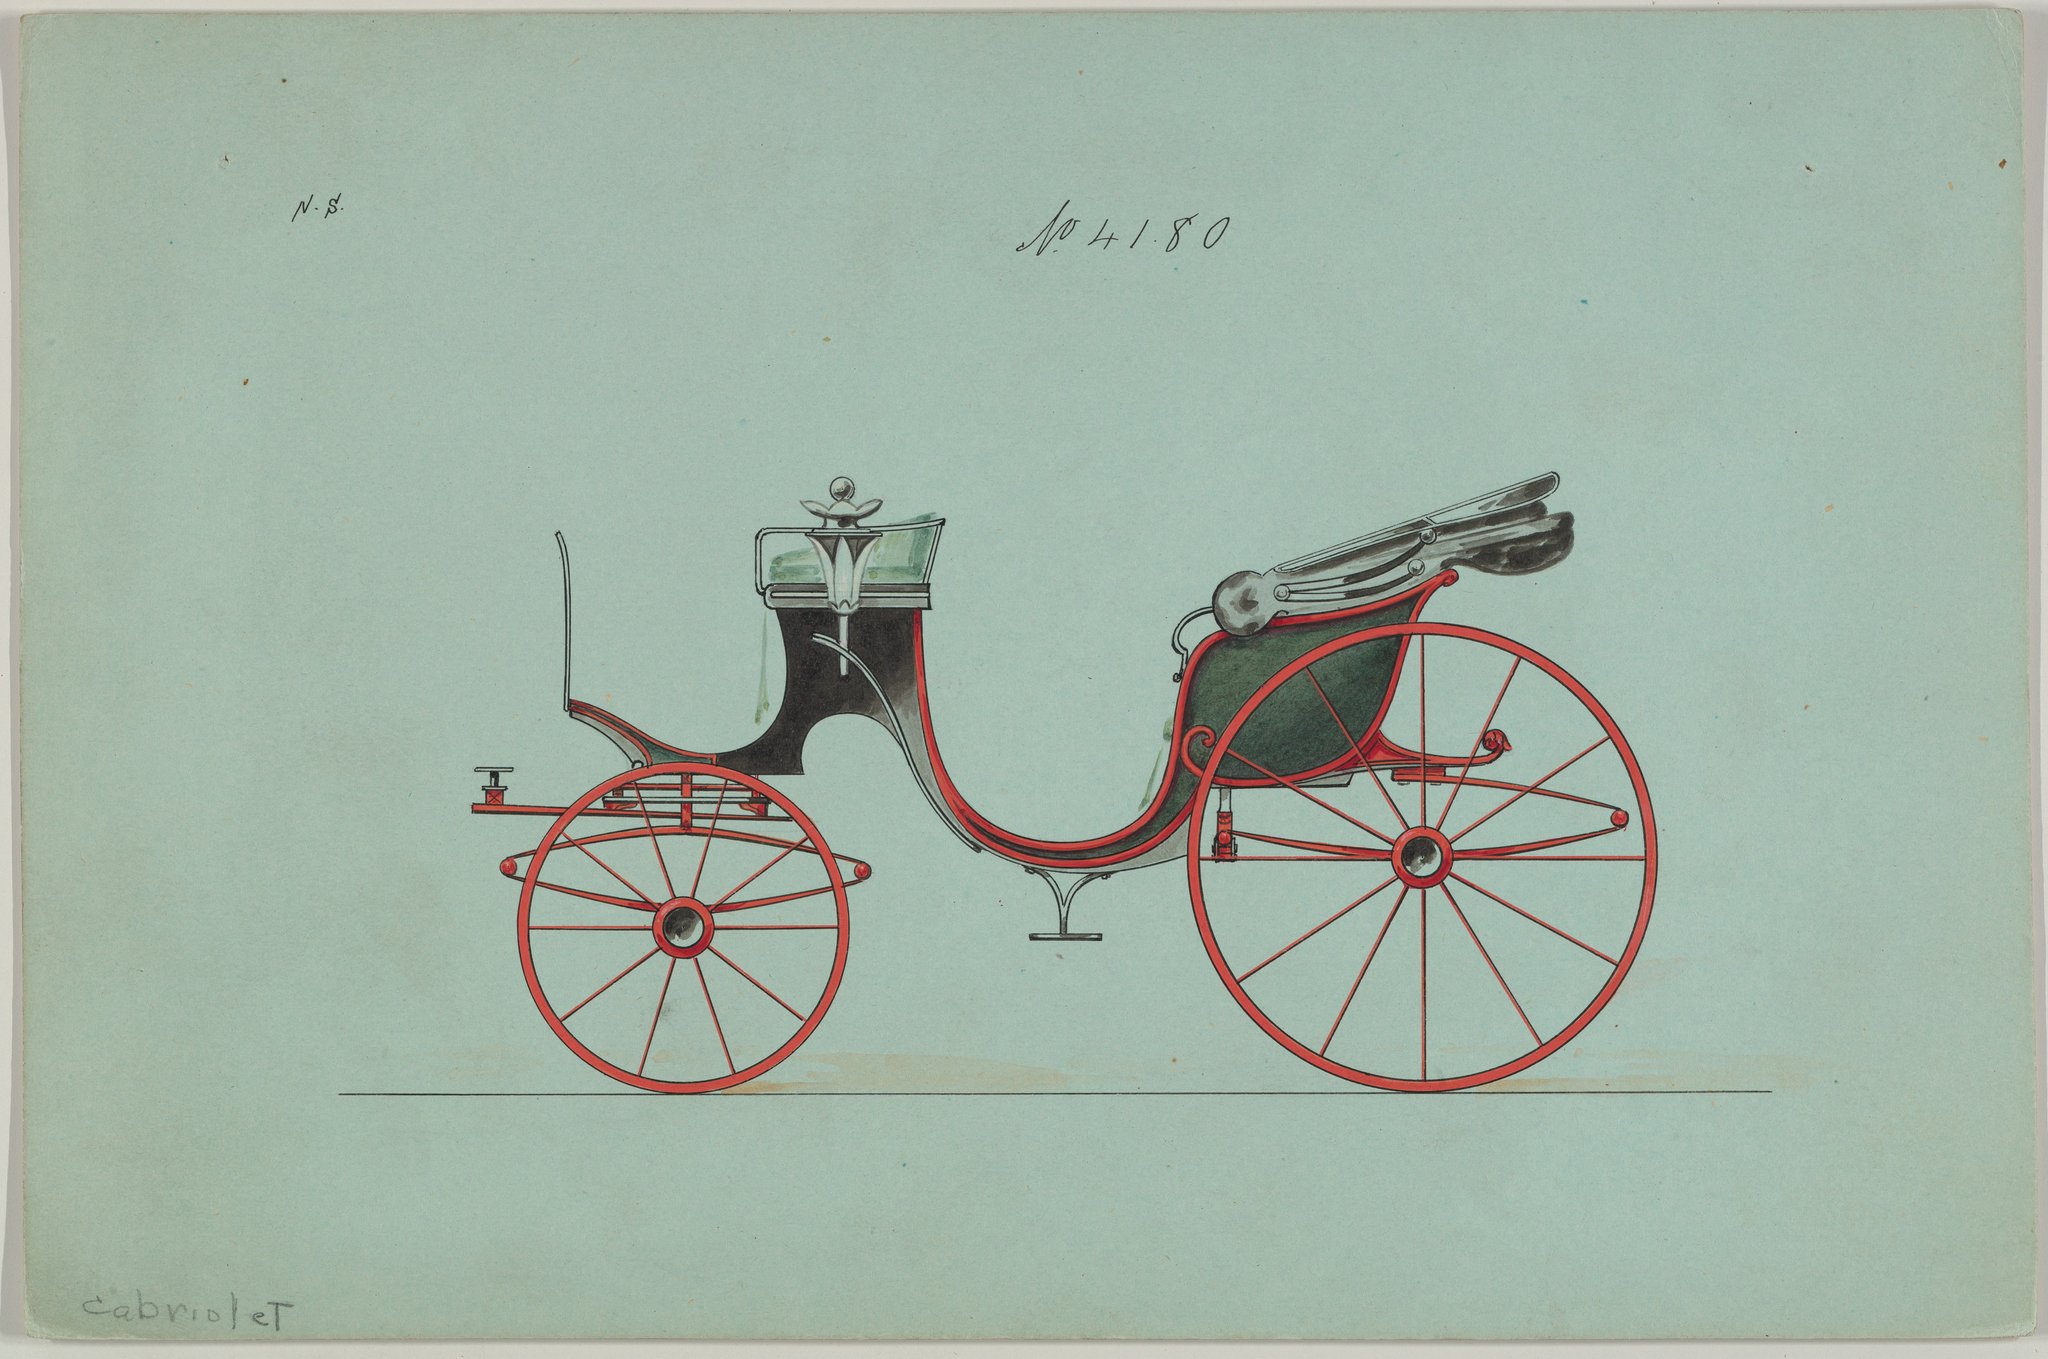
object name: drawing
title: Design for Cabriolet or Victoria, no. 4180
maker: brewster & co.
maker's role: manufacturer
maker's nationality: american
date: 1892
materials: ink, watercolor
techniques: pen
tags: carriages